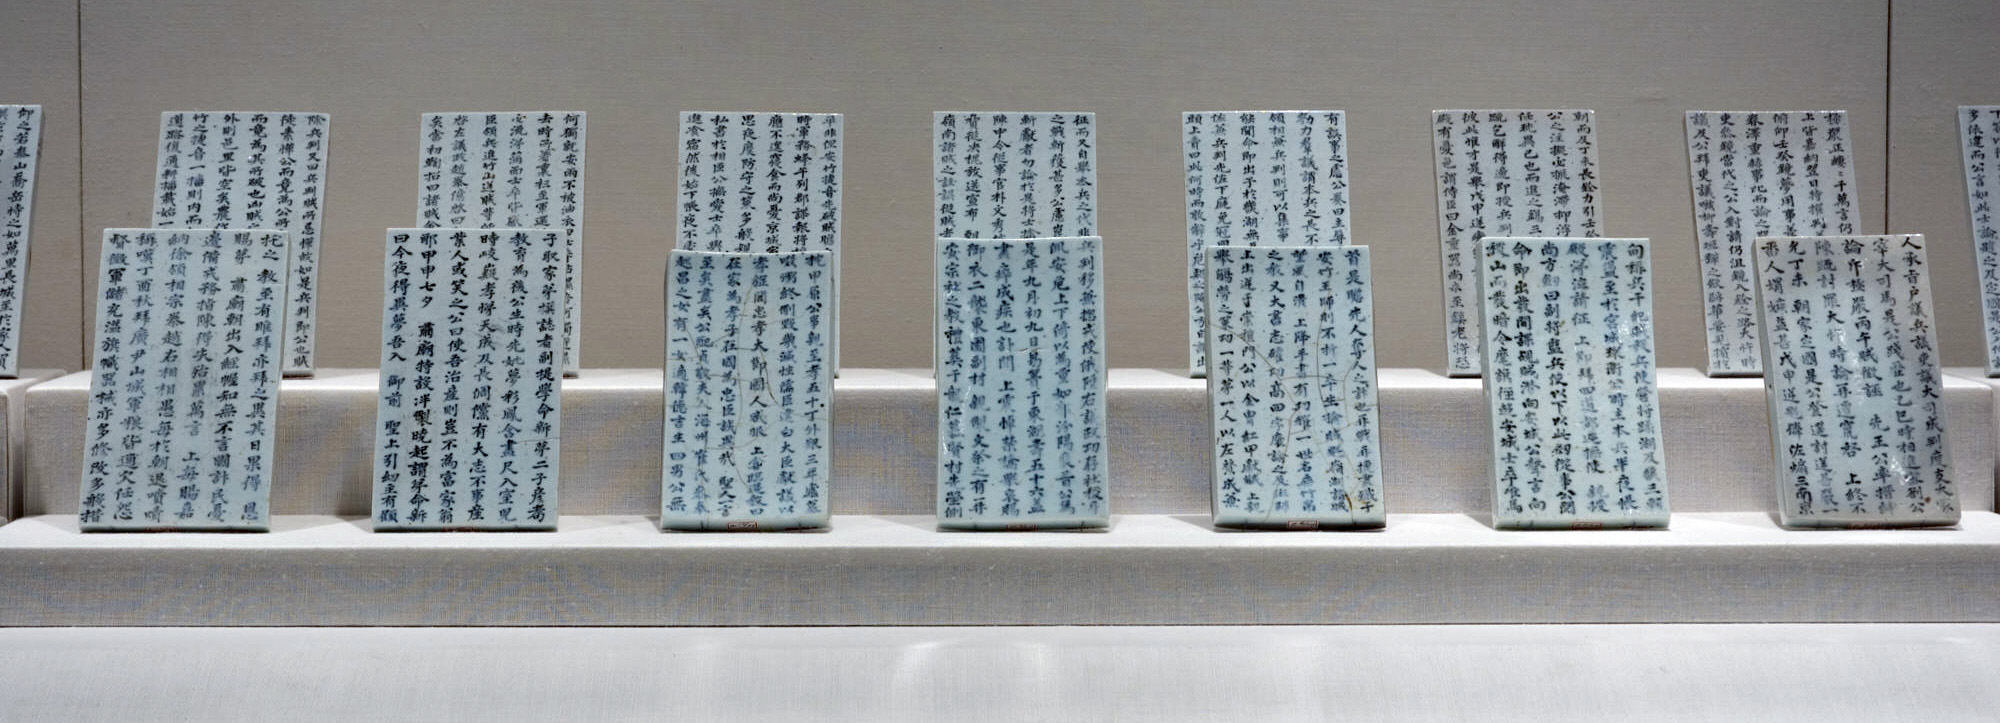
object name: tablet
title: Epitaph tablets (myoji)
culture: korean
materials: cobalt, porcelain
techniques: underglaze